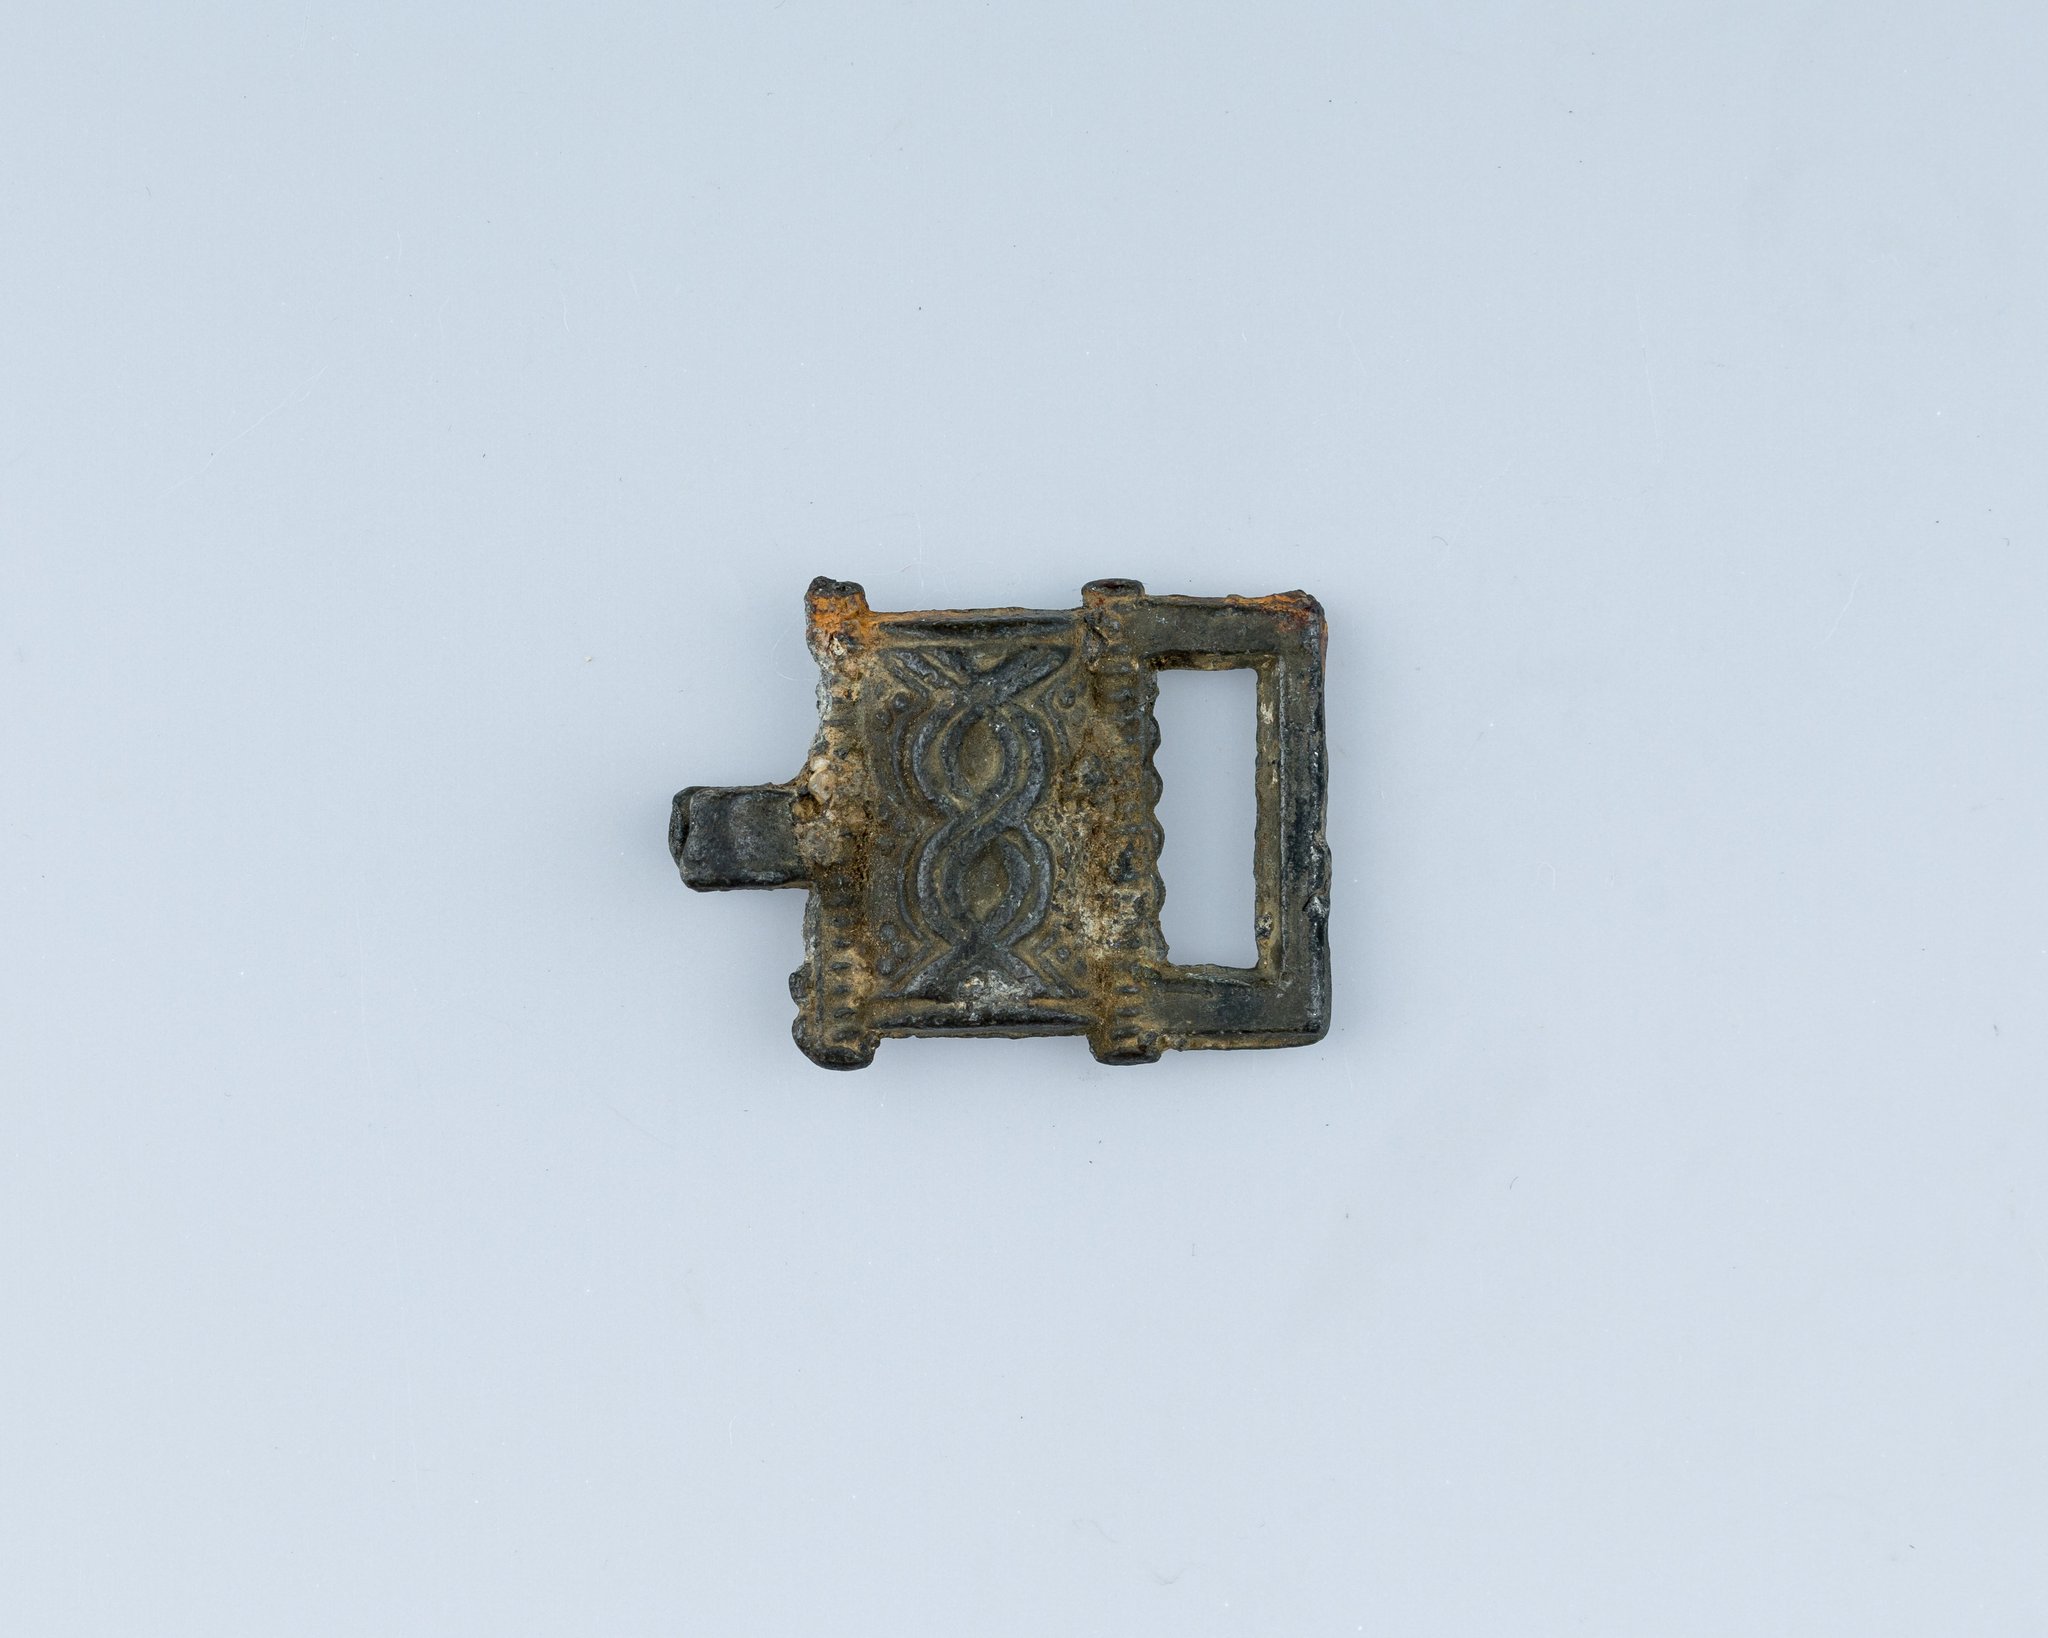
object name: pendant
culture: french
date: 1401-1500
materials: bronze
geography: france